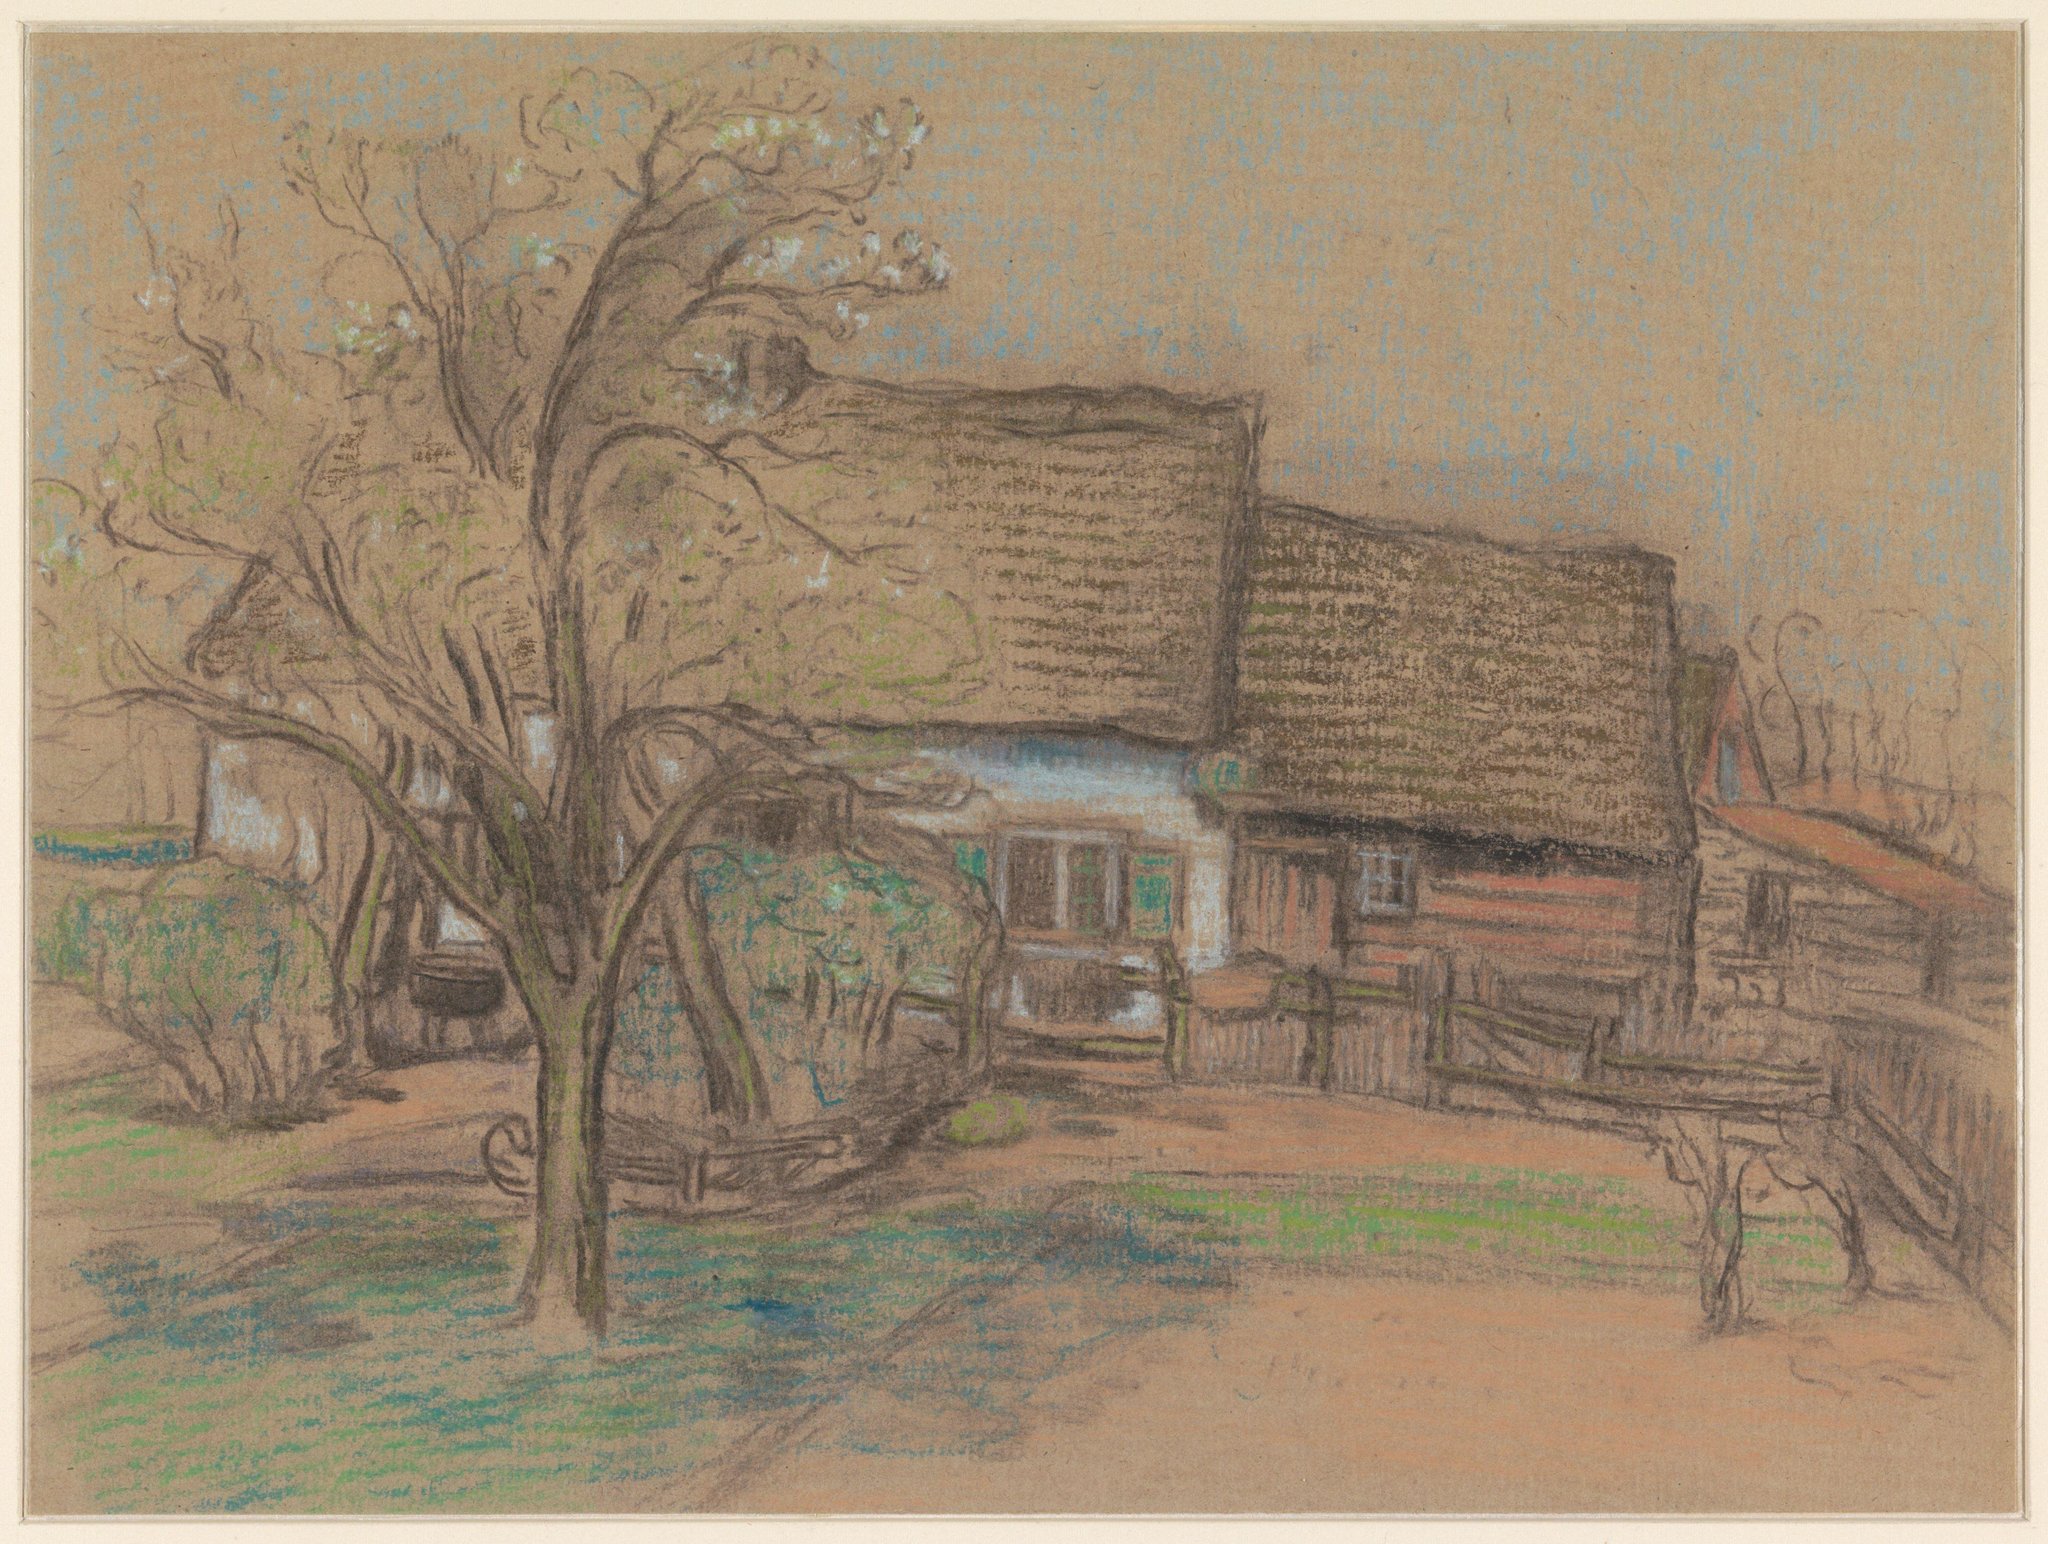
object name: drawing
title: Boerderij met boomgaard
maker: william degouve de nuncques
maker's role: draughtsman, print maker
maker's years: 1867-1935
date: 1918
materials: charcoal, paper, pastel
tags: farm (building)